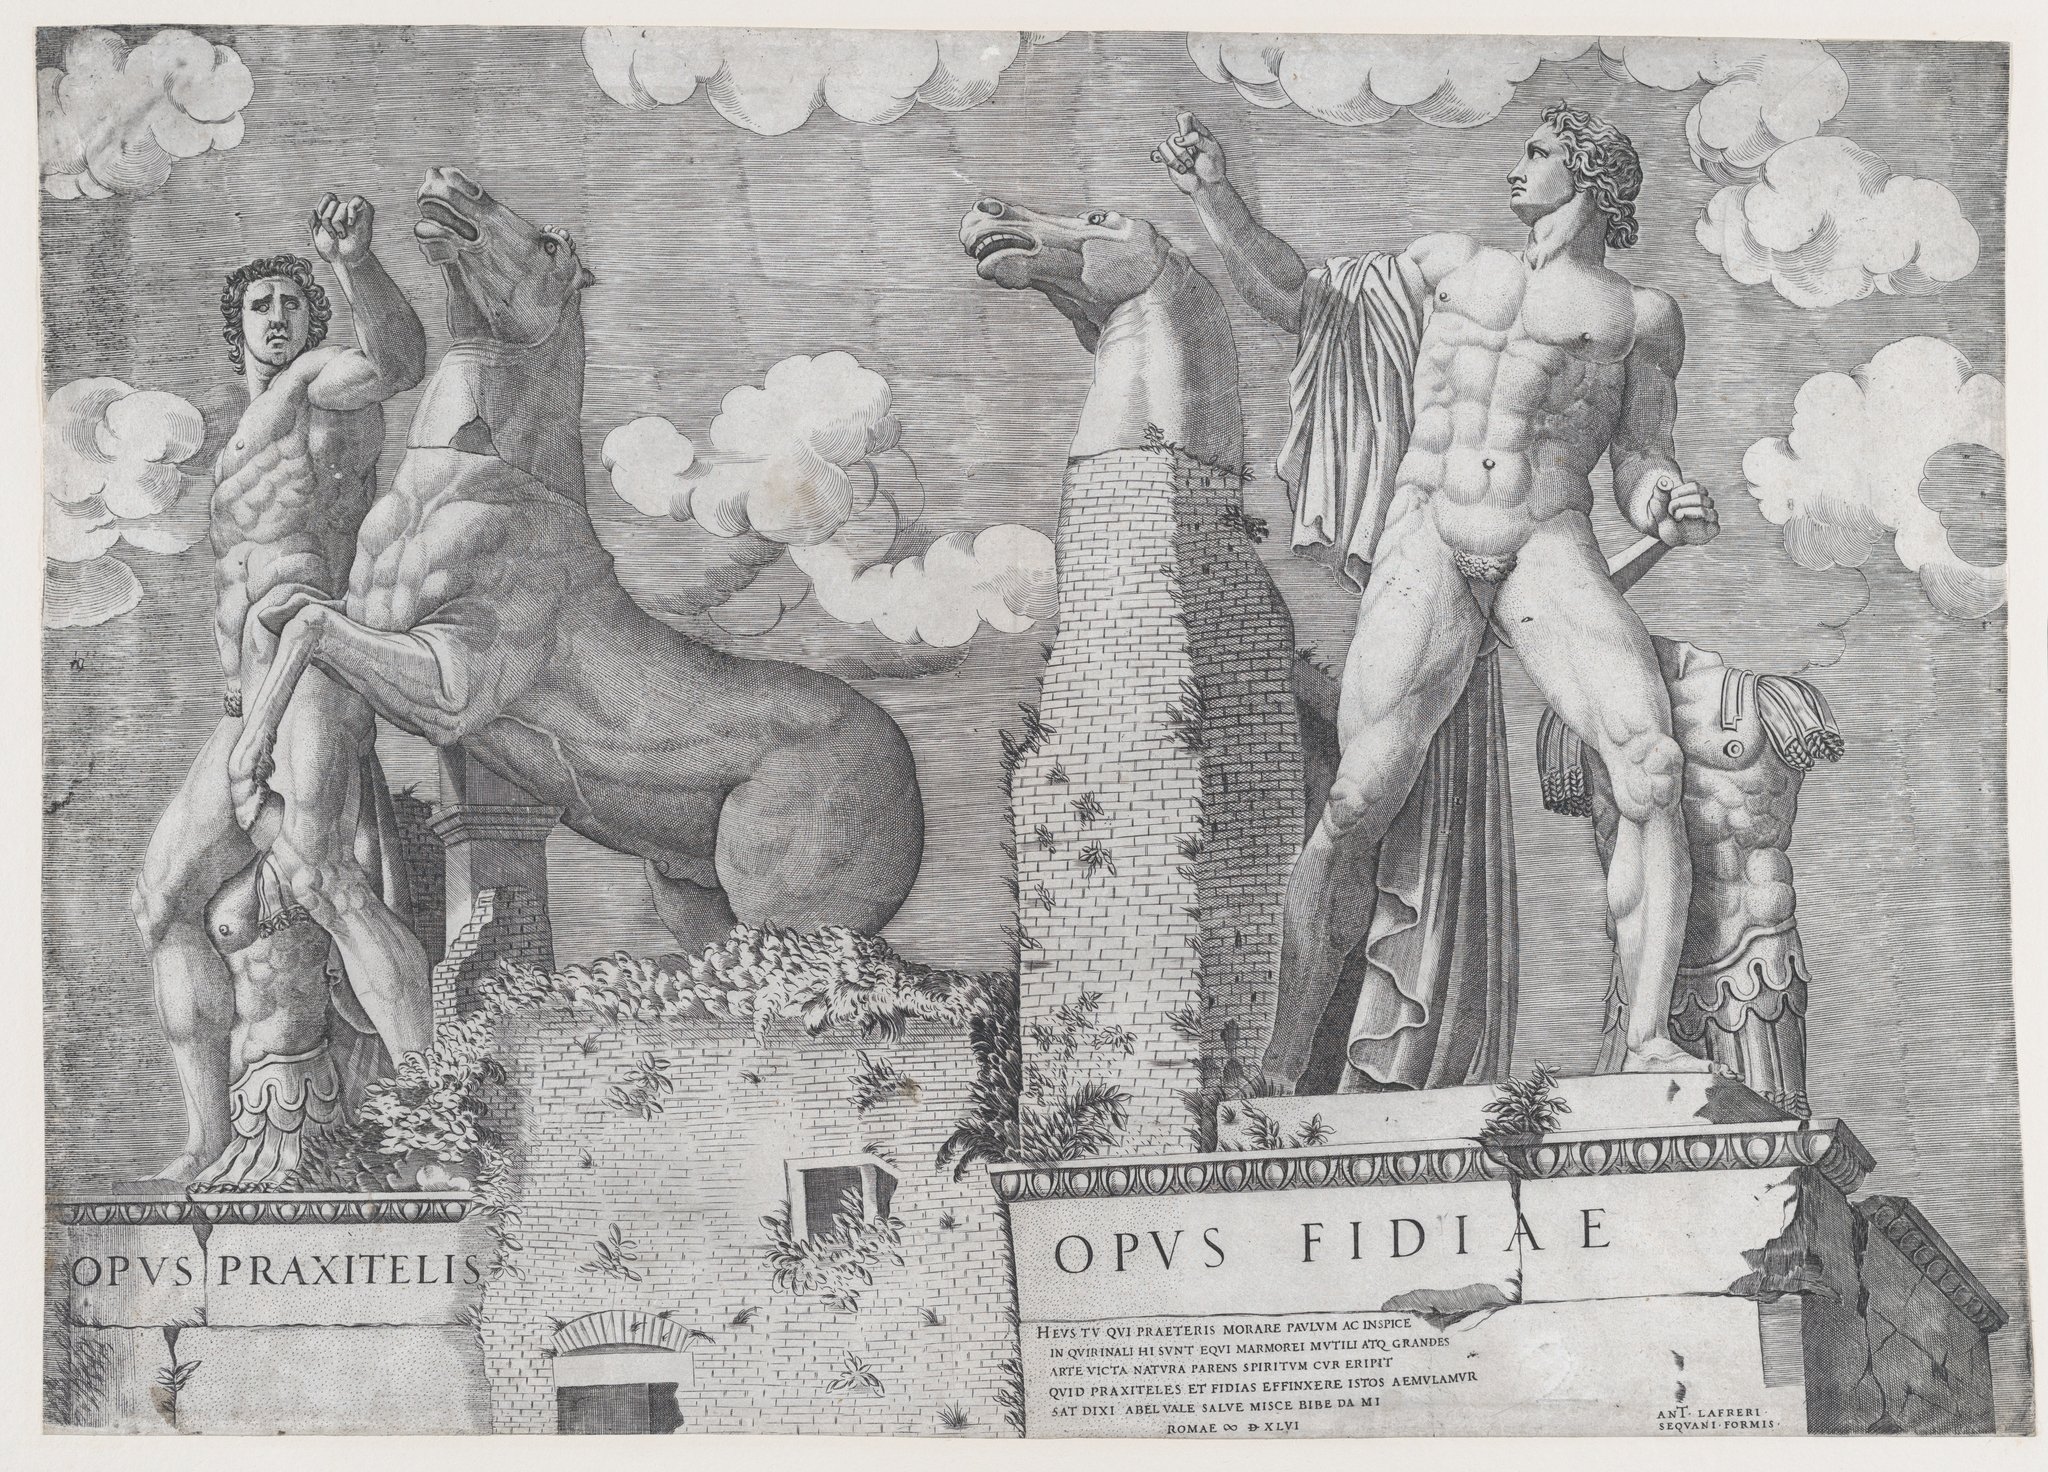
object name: print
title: Statues of the Dioscuri at the Quirinal, Rome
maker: Anonymous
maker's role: artist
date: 1546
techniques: engraving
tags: male nudes,horses